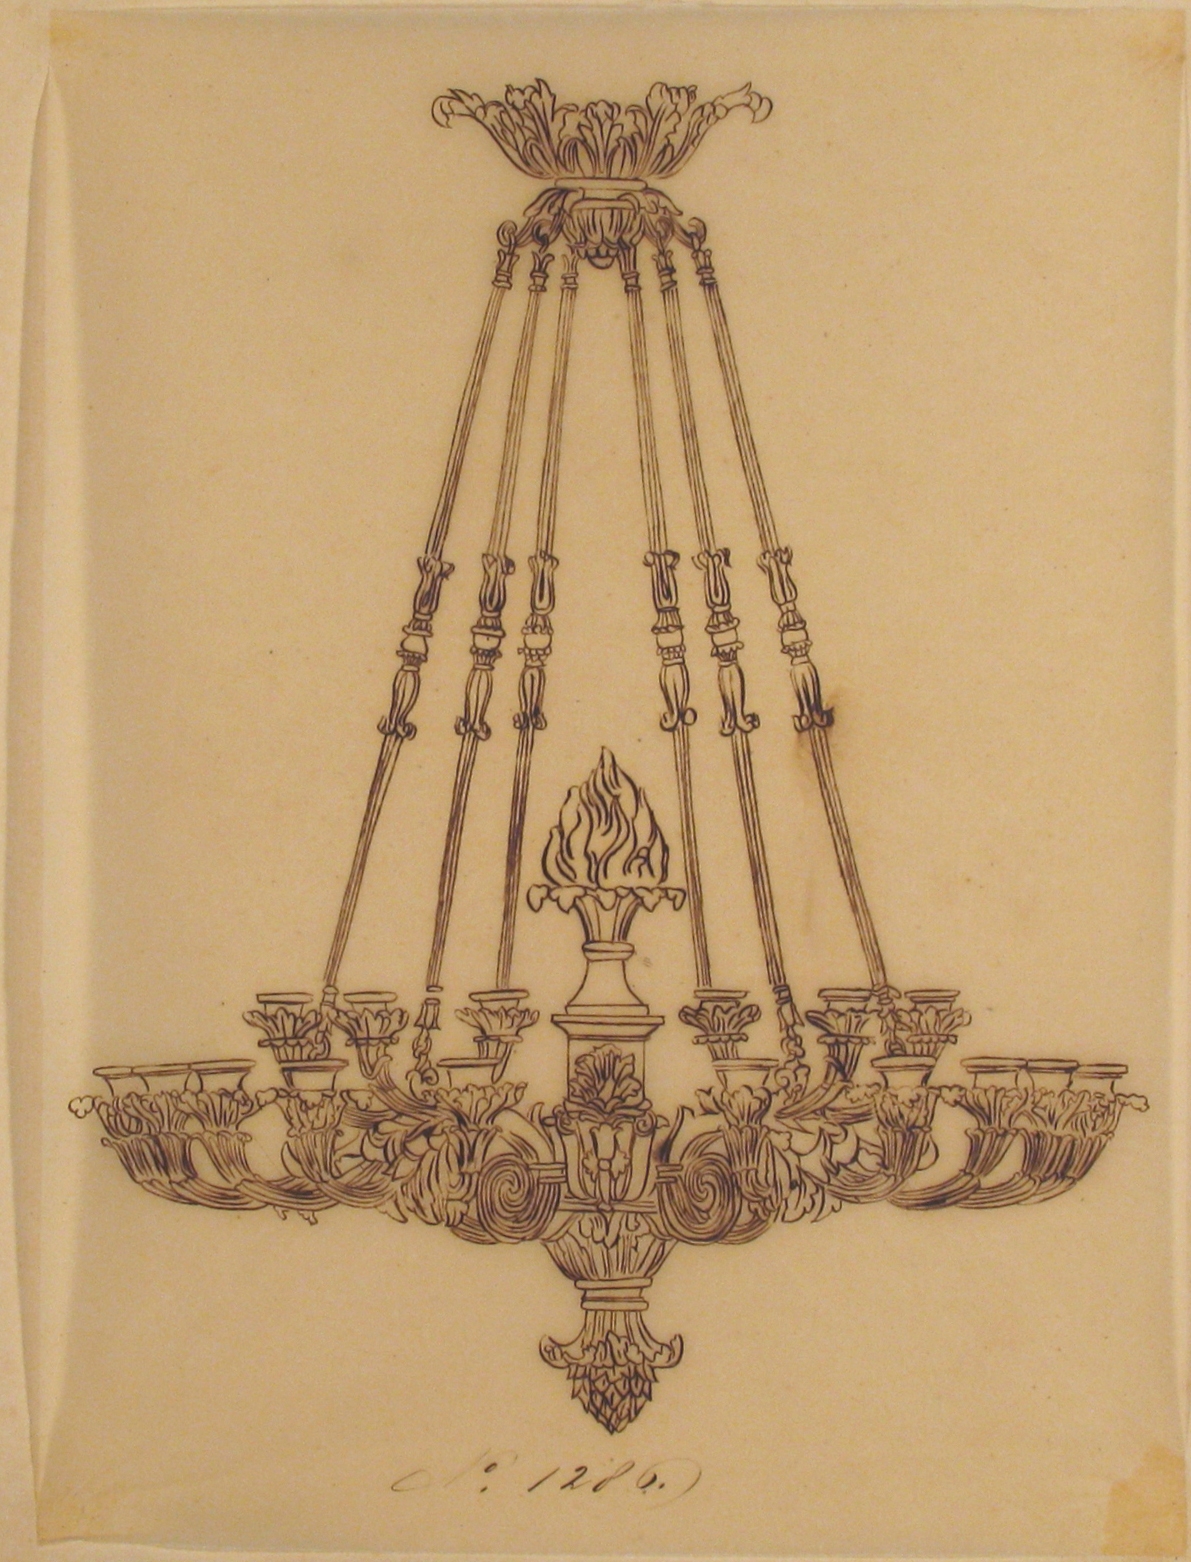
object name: drawing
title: Design for a Chandelier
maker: anonymous, french, 19th century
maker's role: artist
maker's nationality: french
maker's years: 1800-1900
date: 1801-1900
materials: ink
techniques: pen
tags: chandelier